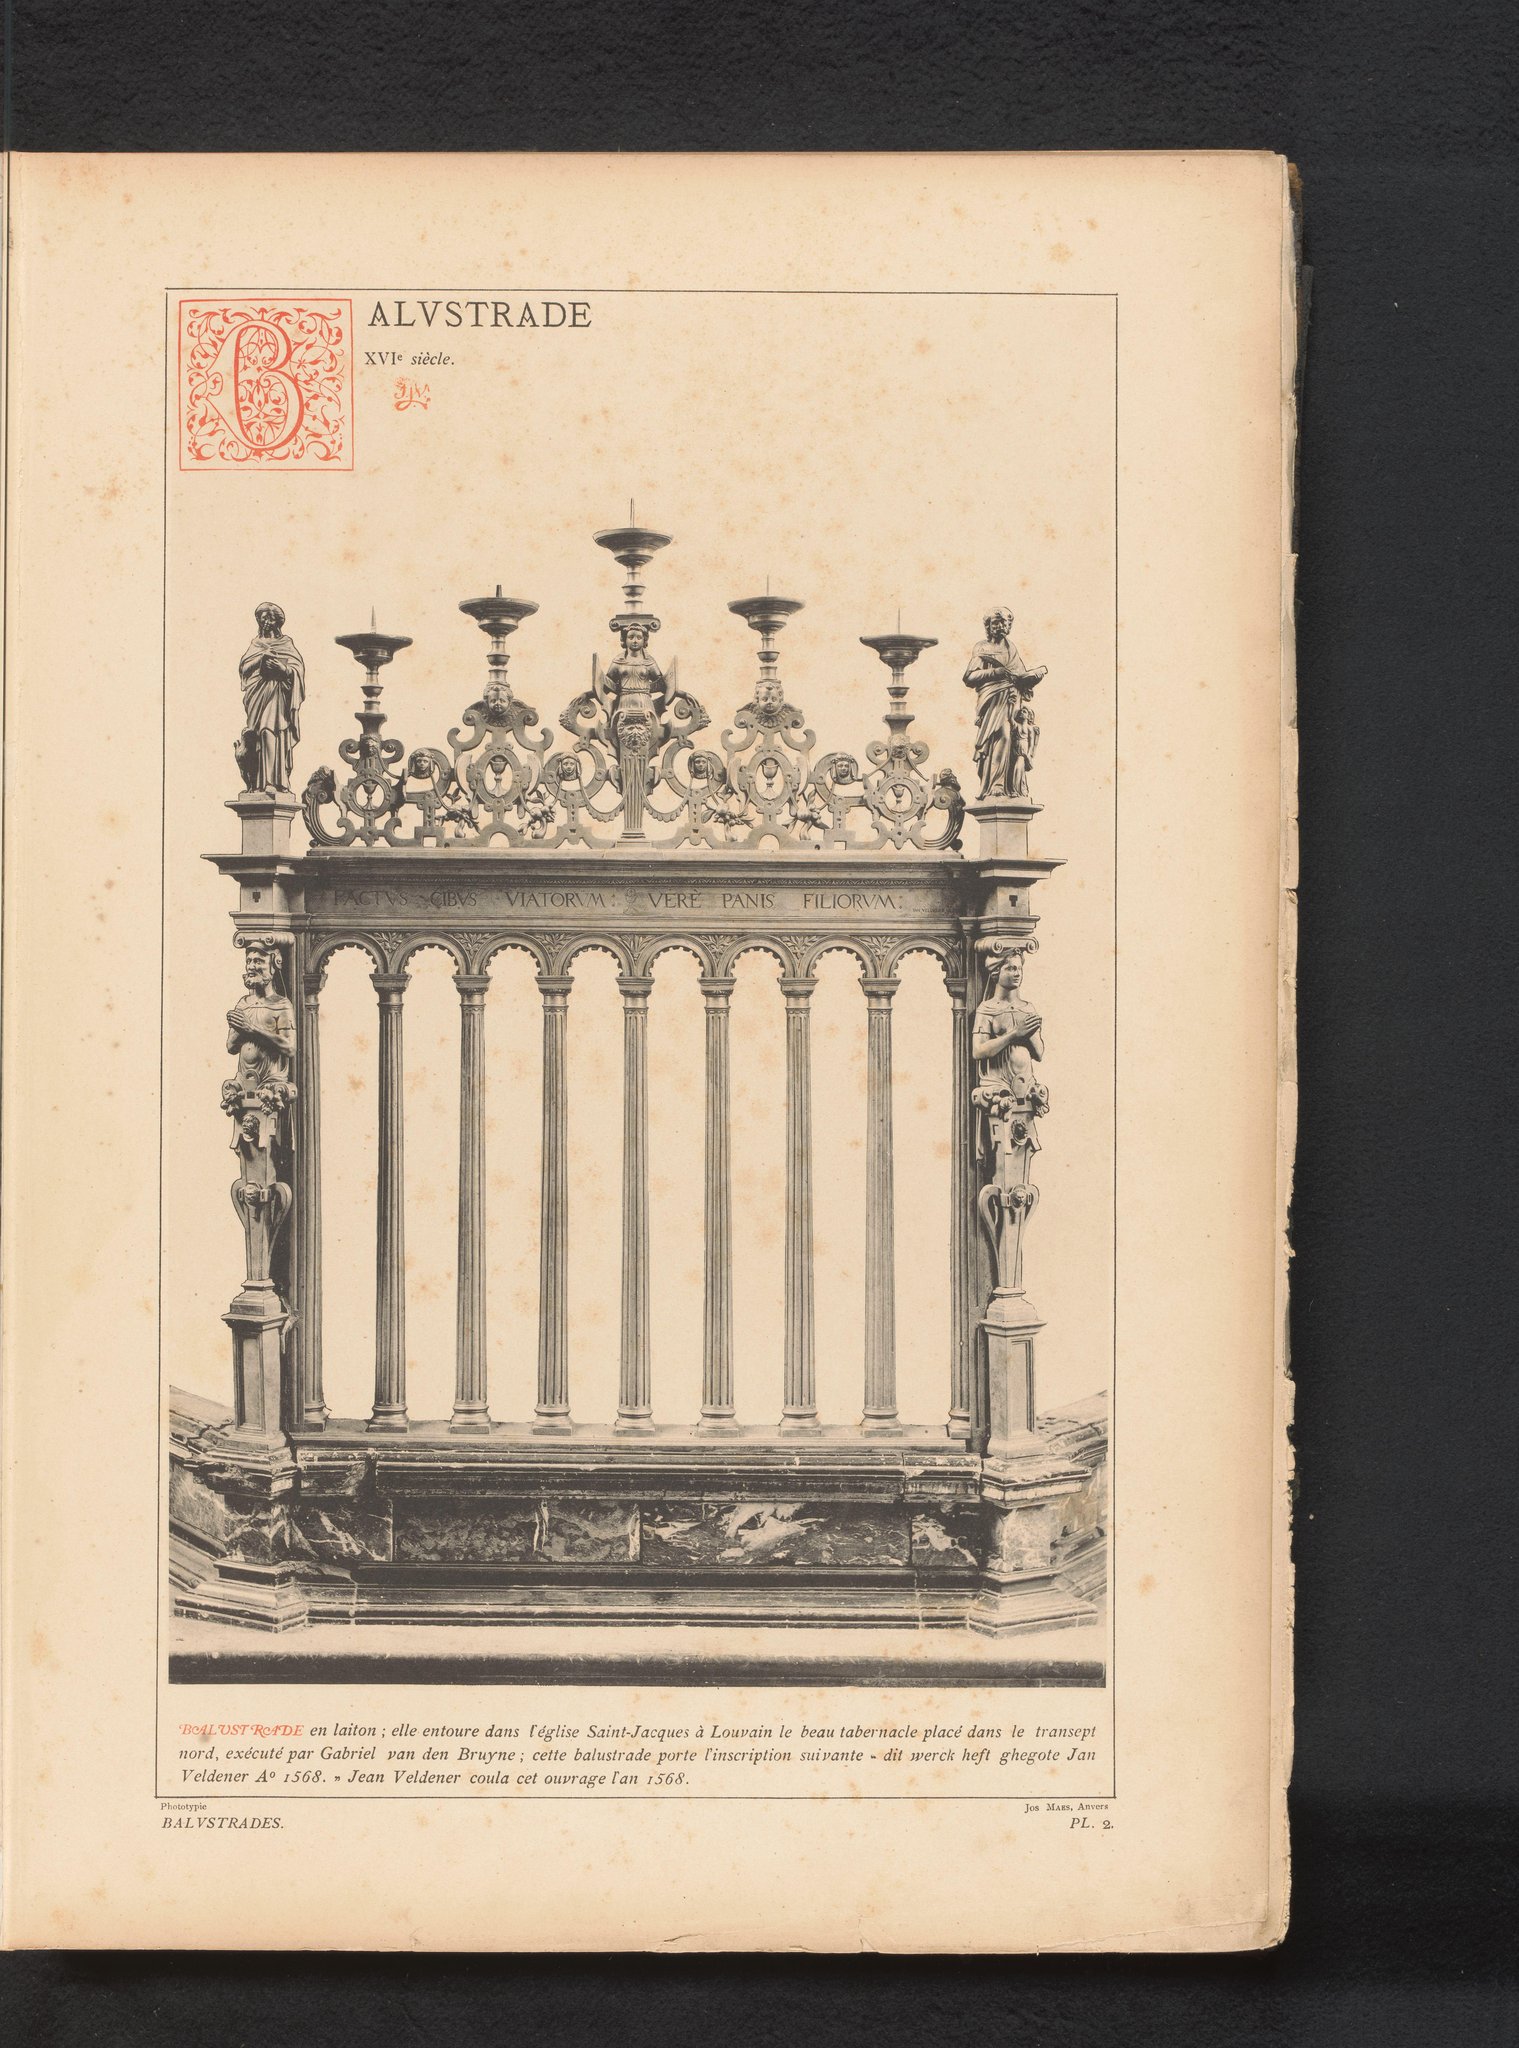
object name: page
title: Balustrade van messing in de Sint-Jacobskerk in Leuven, België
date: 1882-1887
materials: paper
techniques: photograph, photolithography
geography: antwerp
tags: balustrade, interior of church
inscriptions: inscription: ‘BALUSTRADES. - PL. 2.’, inscription: ‘BALUSTRADE en laiton (...)’, monogram: ‘JJvY’